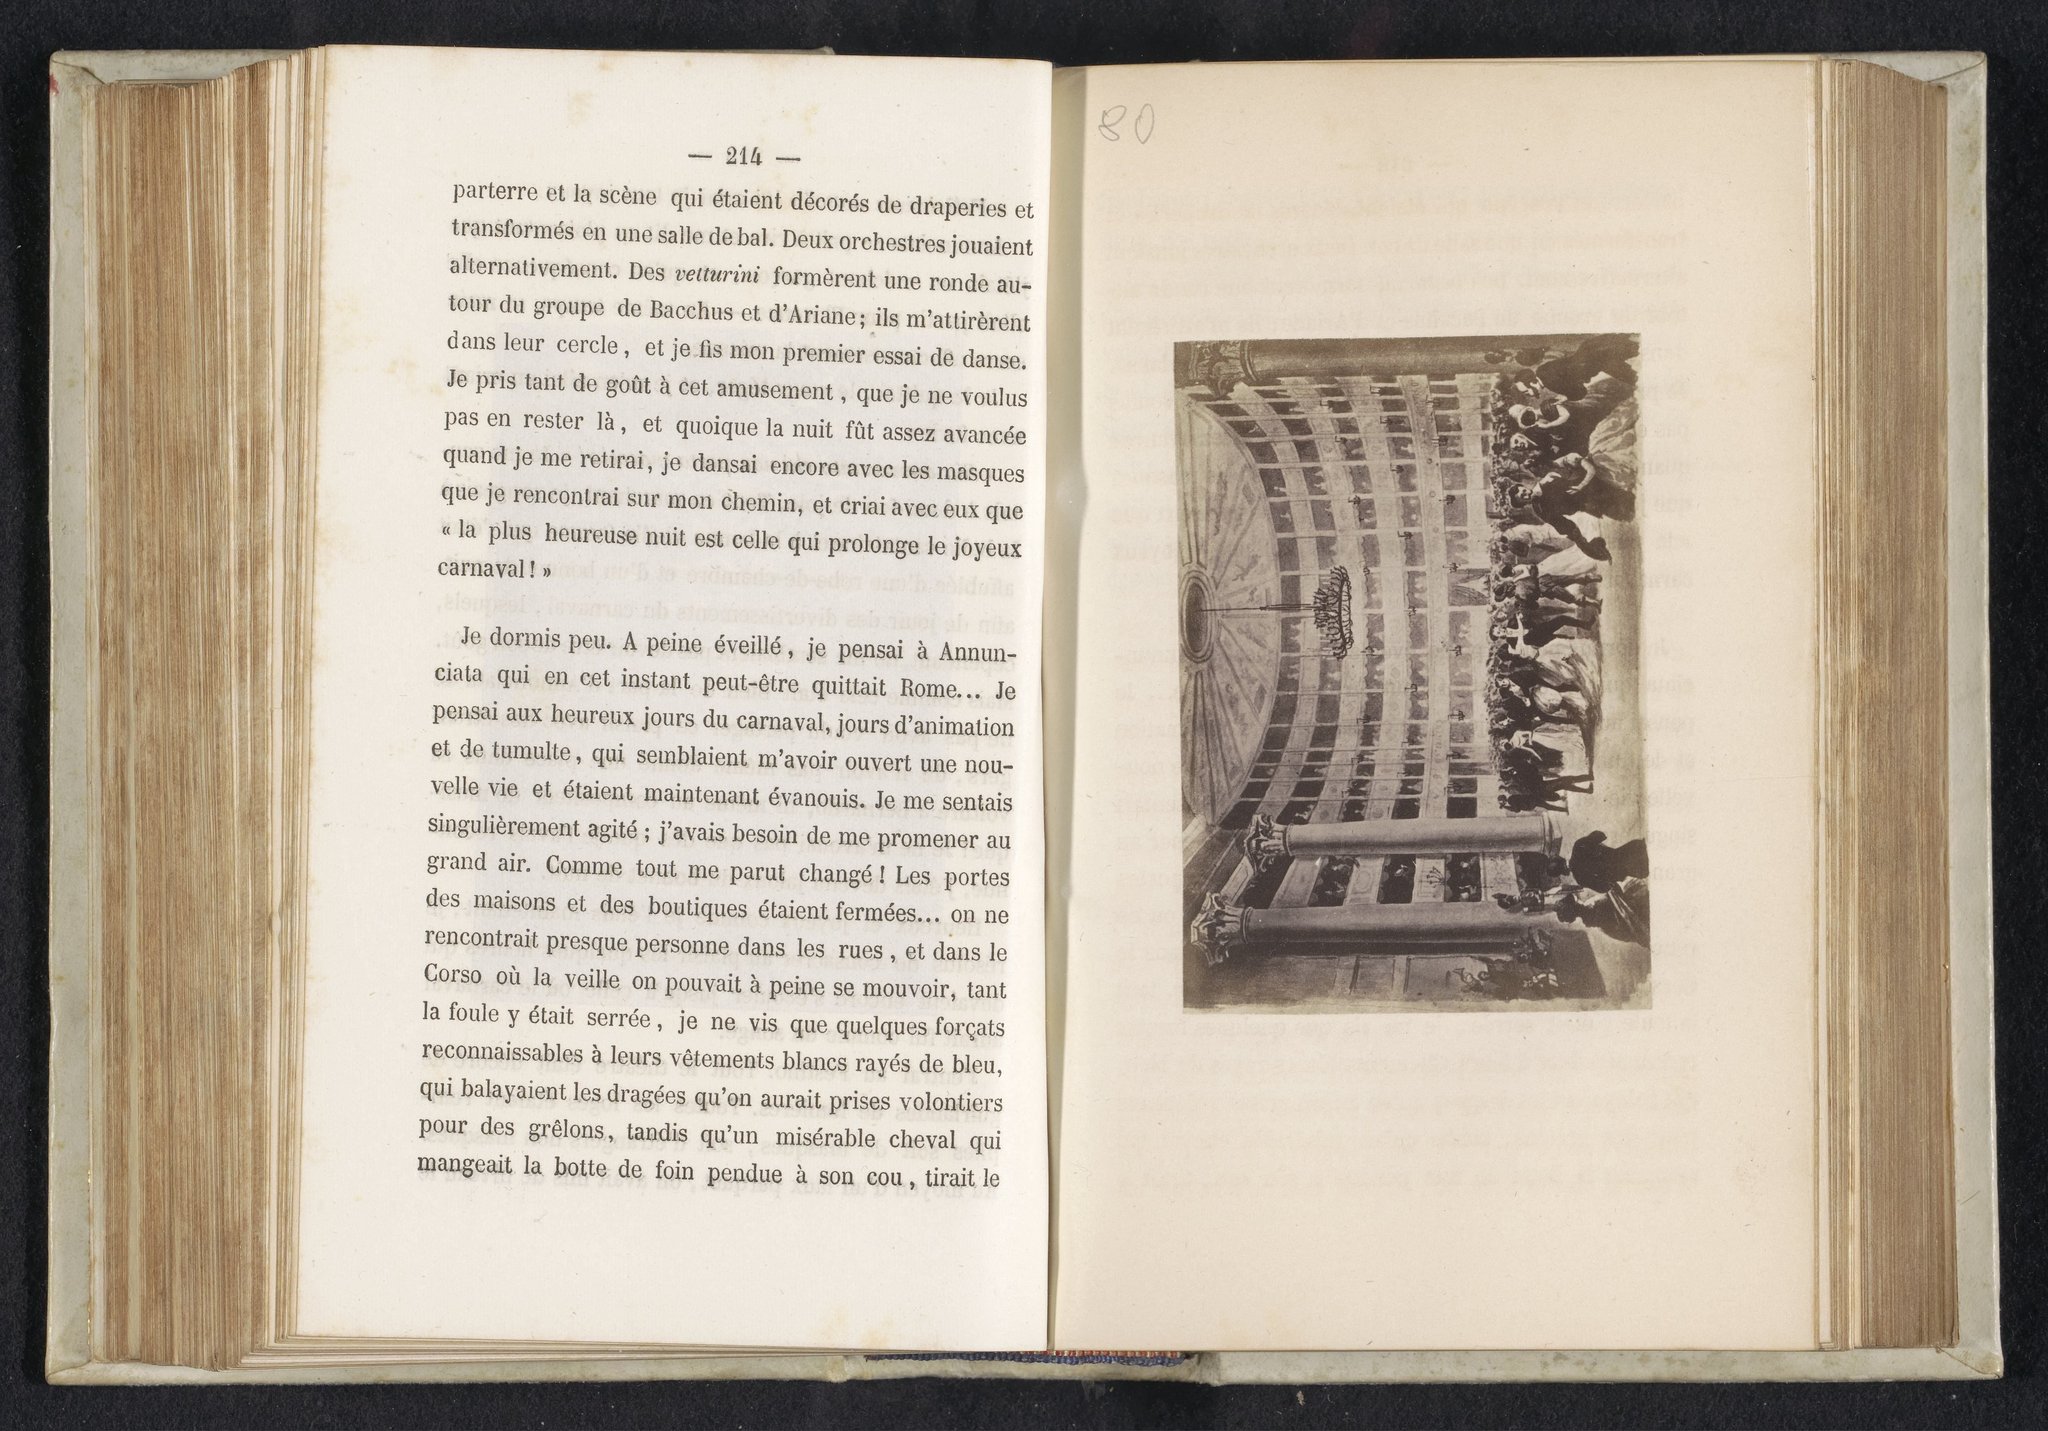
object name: page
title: Fotoreproductie van een schilderij, voorstellende dansende mensen in een zaal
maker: Anonymous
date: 1850-1860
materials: photographic support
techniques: albumen print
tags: ball, formal dance